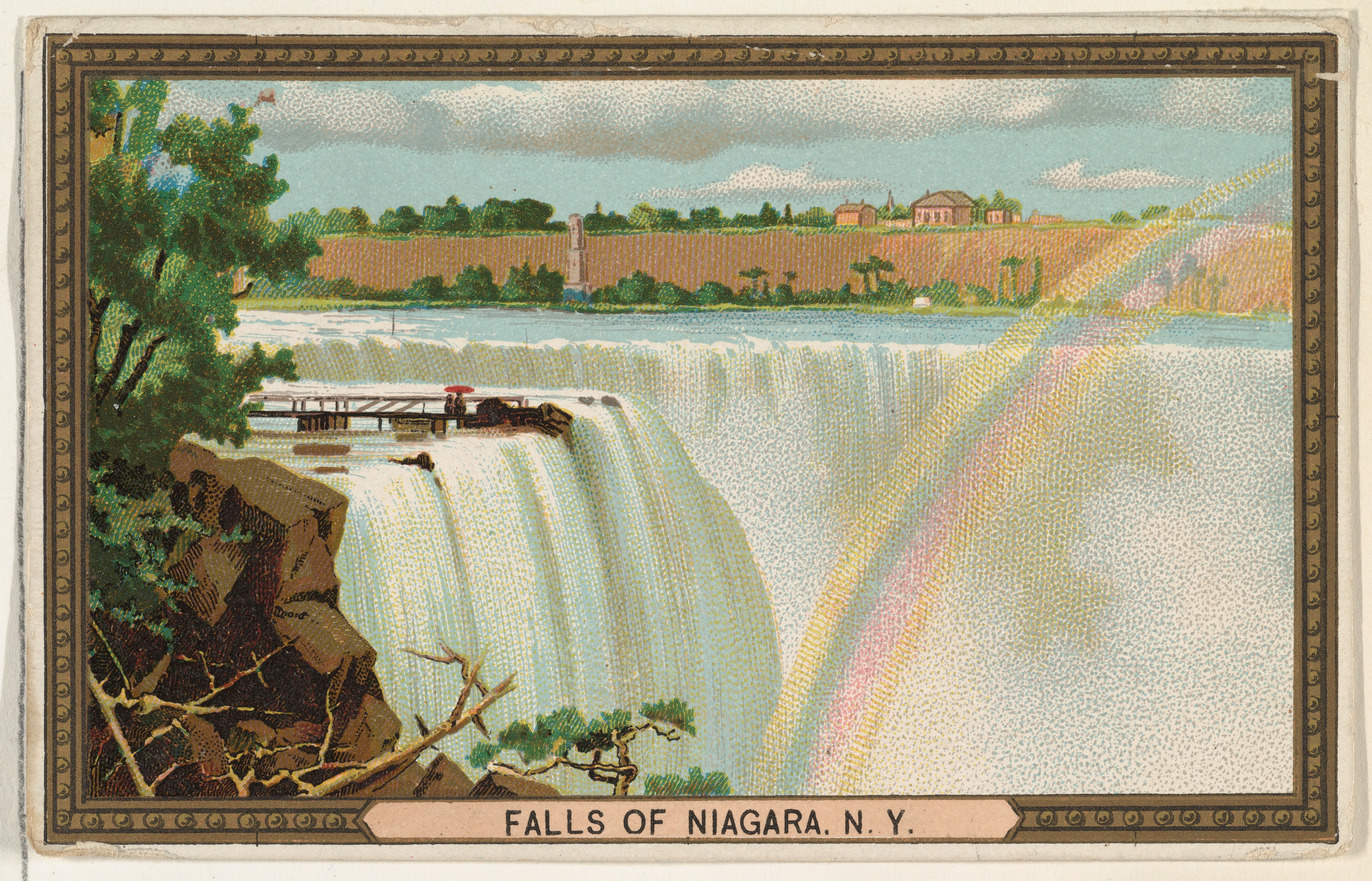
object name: print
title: Falls of Niagara, New York, from the Rulers, Flags, and Coats of Arms series (N126-1) issued by W. Duke, Sons & Co.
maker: w. duke, sons & co.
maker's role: publisher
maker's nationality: american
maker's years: 1870-1920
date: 1888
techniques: color lithograph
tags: waterfalls,rainbows